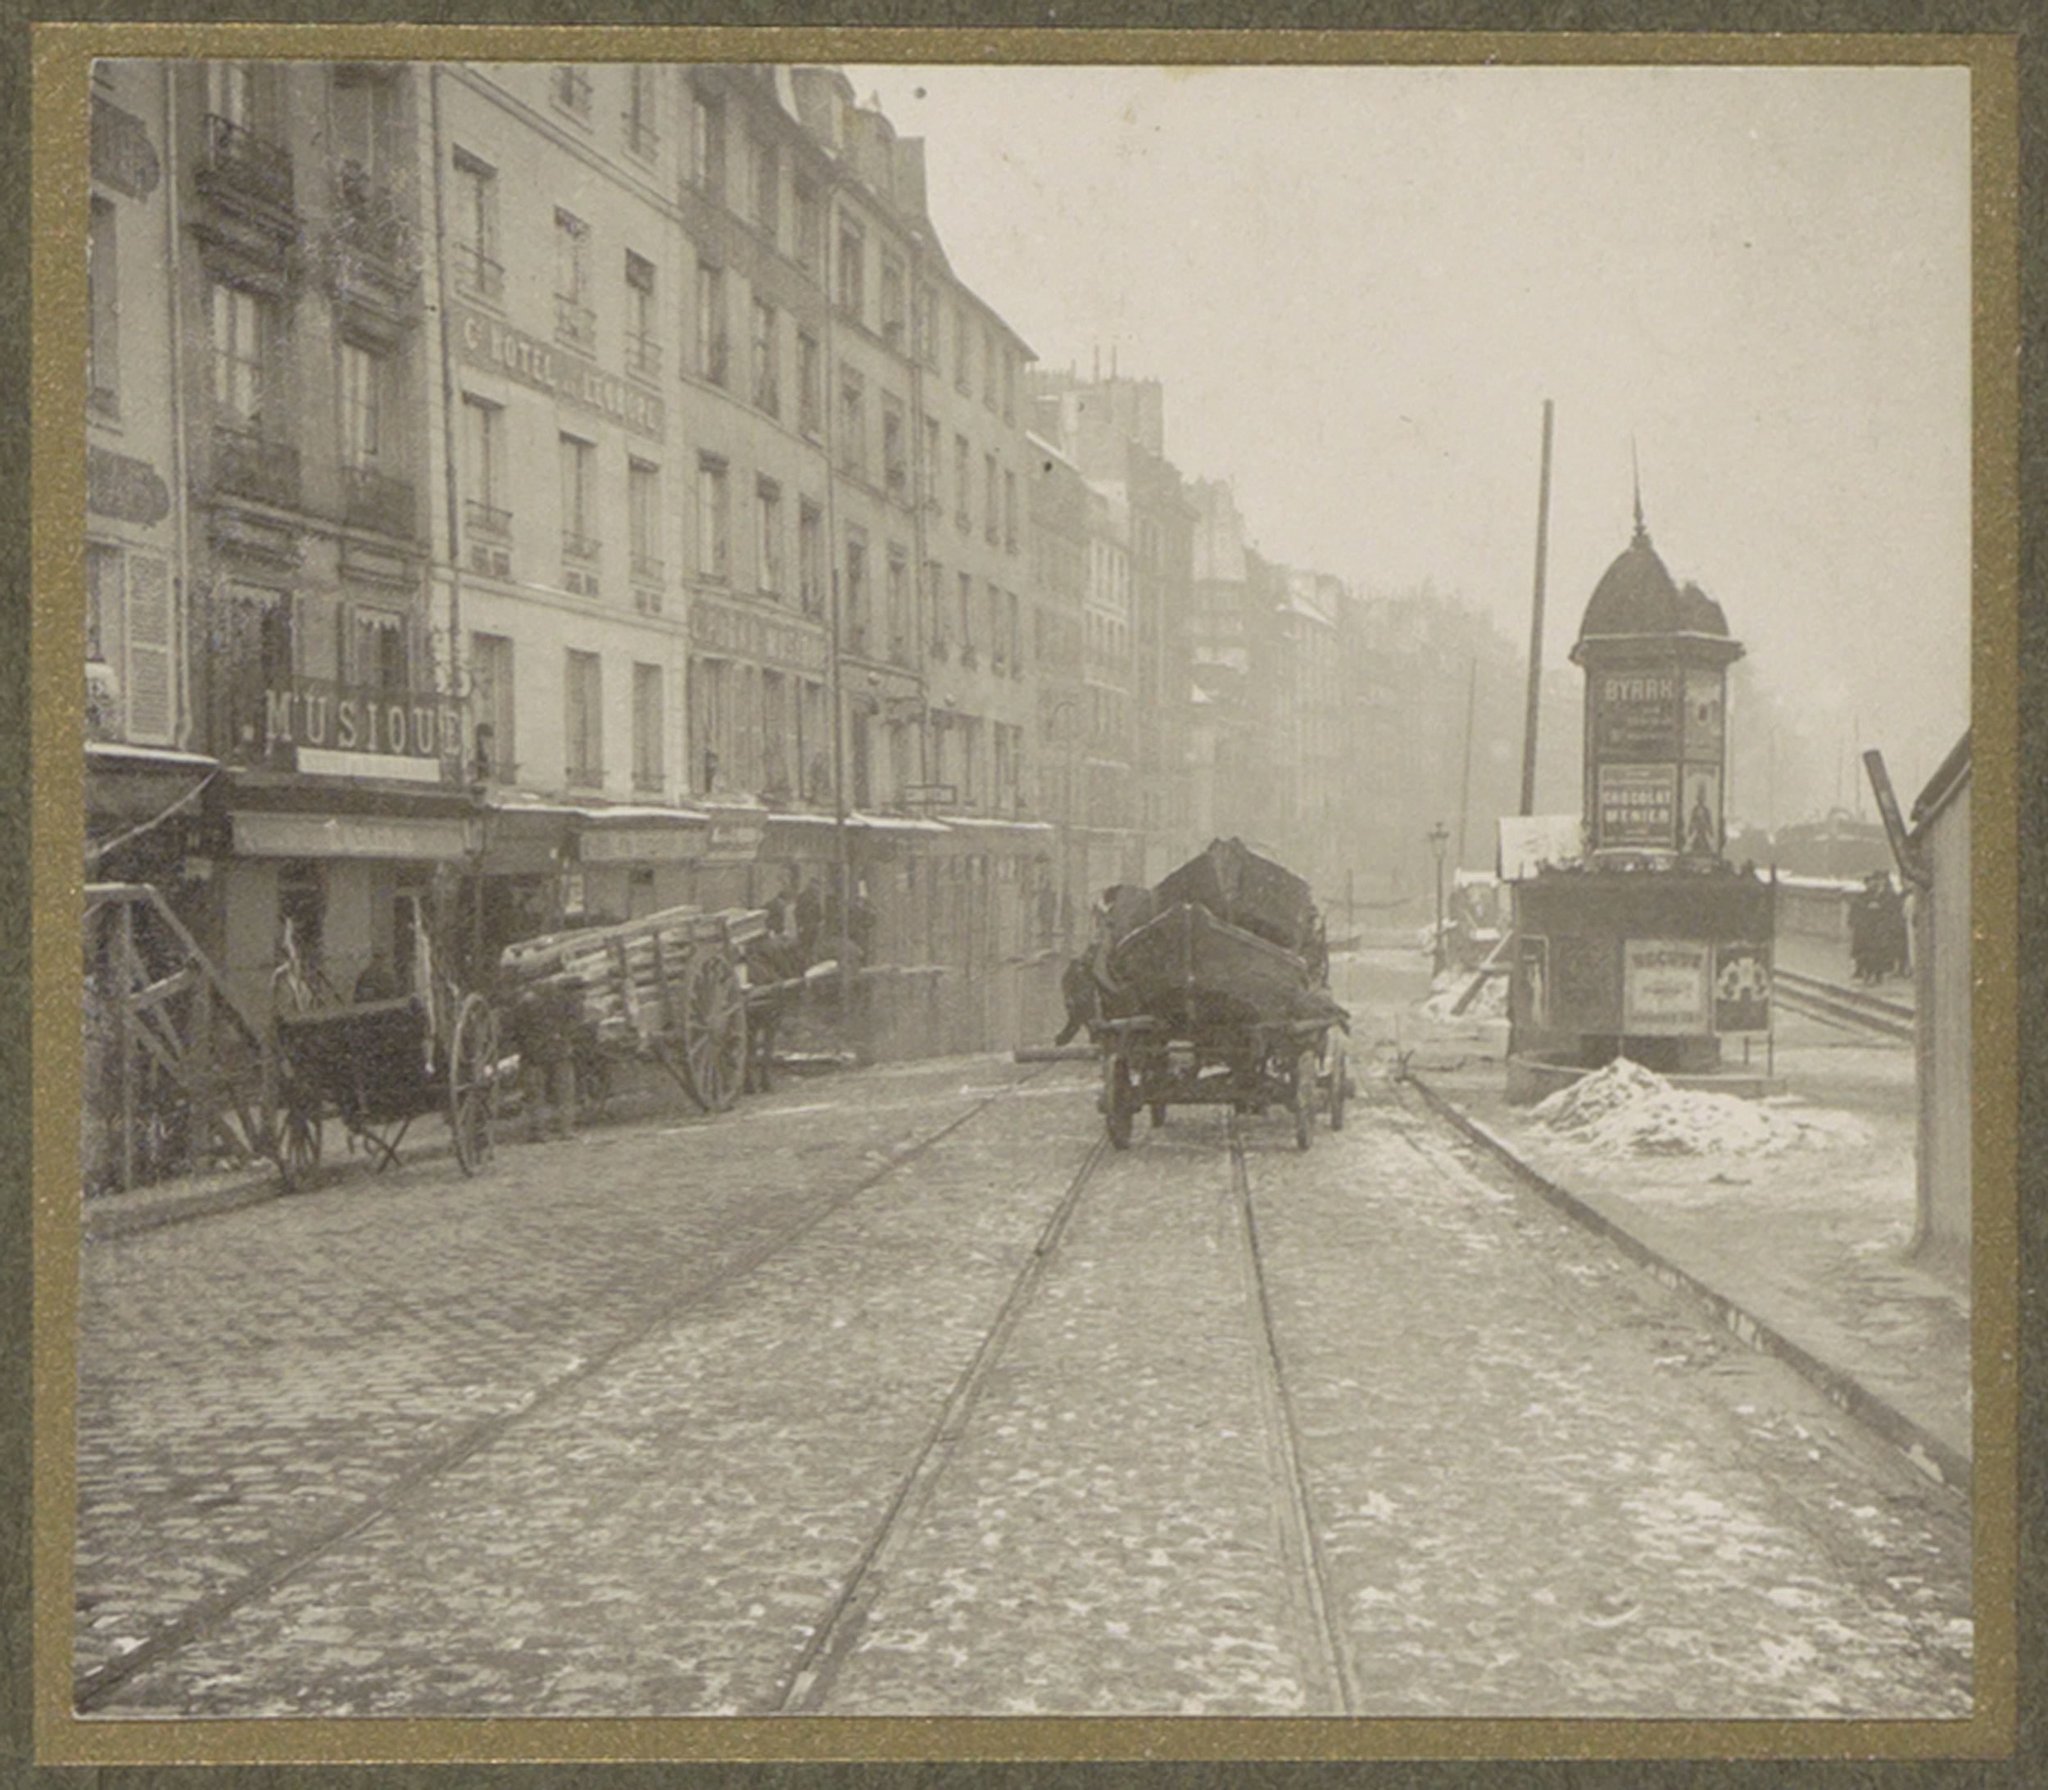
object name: photograph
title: Met hout en vaartuig beladen handkarren in een straat tijdens de overstroming van Parijs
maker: g. dangereux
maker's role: fotograaf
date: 1901-1910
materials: photographic support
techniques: matte daylight collodion silver print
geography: paris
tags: hand-cart, flood (+ landscape with figures, staffage), paris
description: Onderdeel van fotoalbum overstroming Parijs en voorsteden 1910.